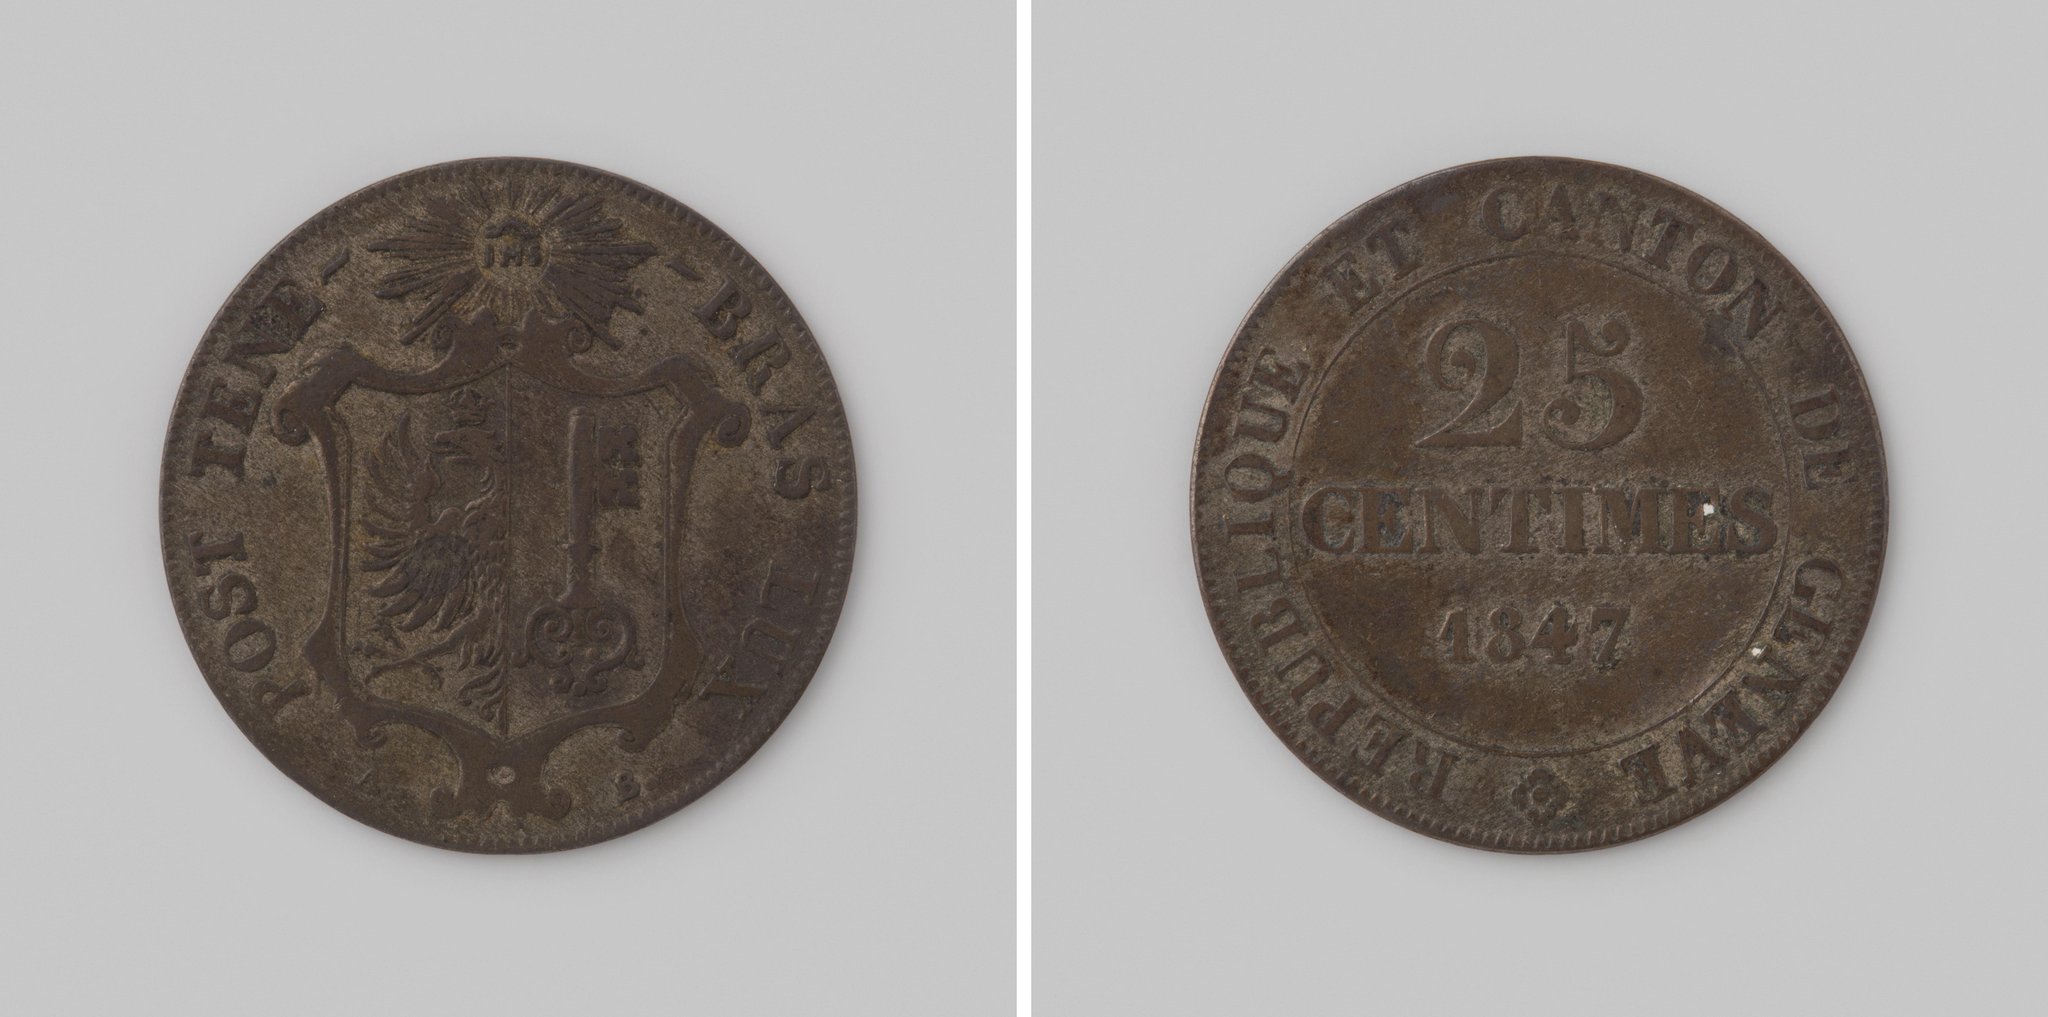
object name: vijfentwintig centime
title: Kanton Geneve, 25 centimes, 1847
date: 1847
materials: silver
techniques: striking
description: Zilveren munt. Voorzijde: versierd wapenschild van Geneve. Daarboven binnen stralende zon de letters I,H en S. Keerzijde: waarde-aanduiding in twee regels, waaronder jaartal. Gladde rand.